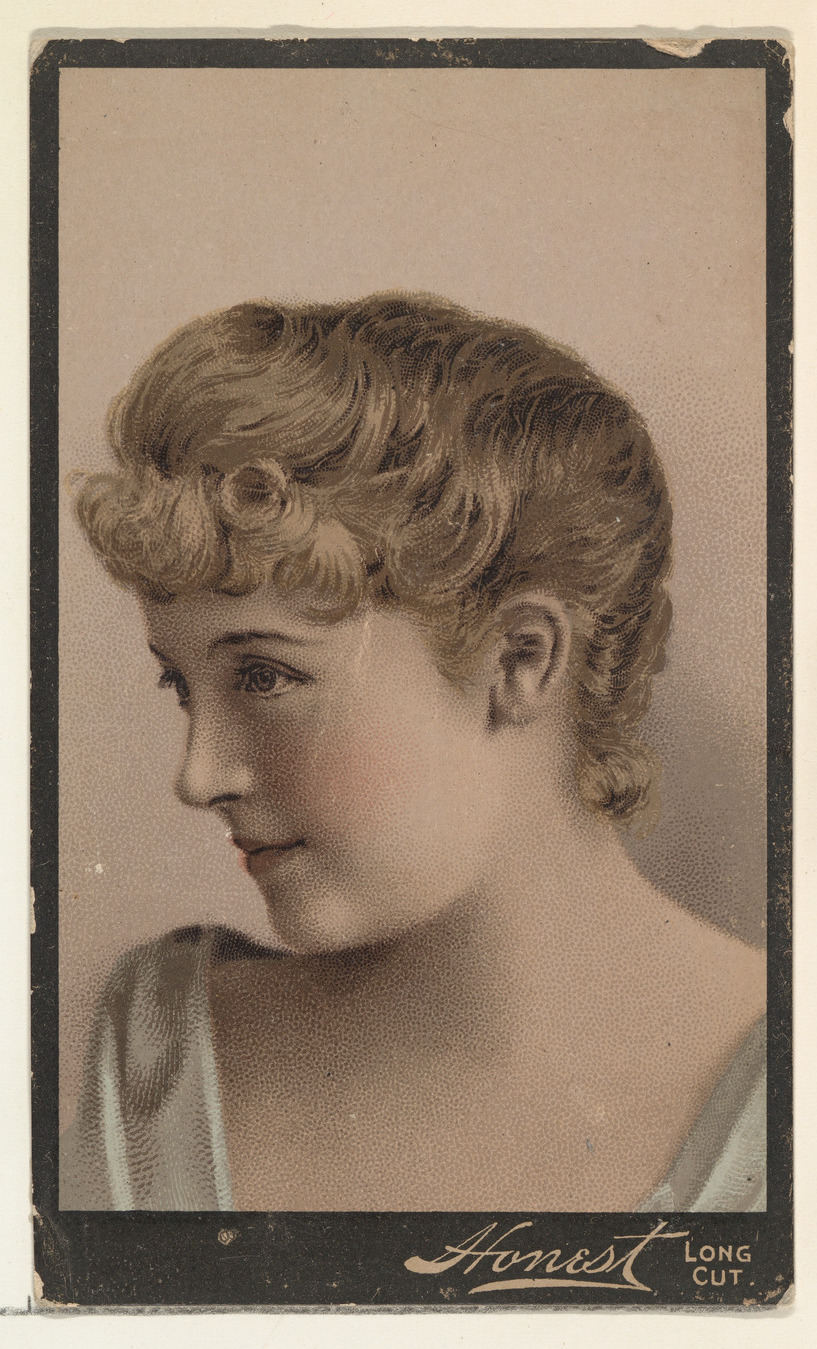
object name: print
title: Actress in profile facing left, from Stars of the Stage, Third Series (N131) issued by Duke Sons & Co. to promote Honest Long Cut Tobacco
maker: w. duke, sons & co.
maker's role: publisher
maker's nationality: american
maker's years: 1870-1920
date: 1891-1892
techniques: color lithograph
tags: women,actresses